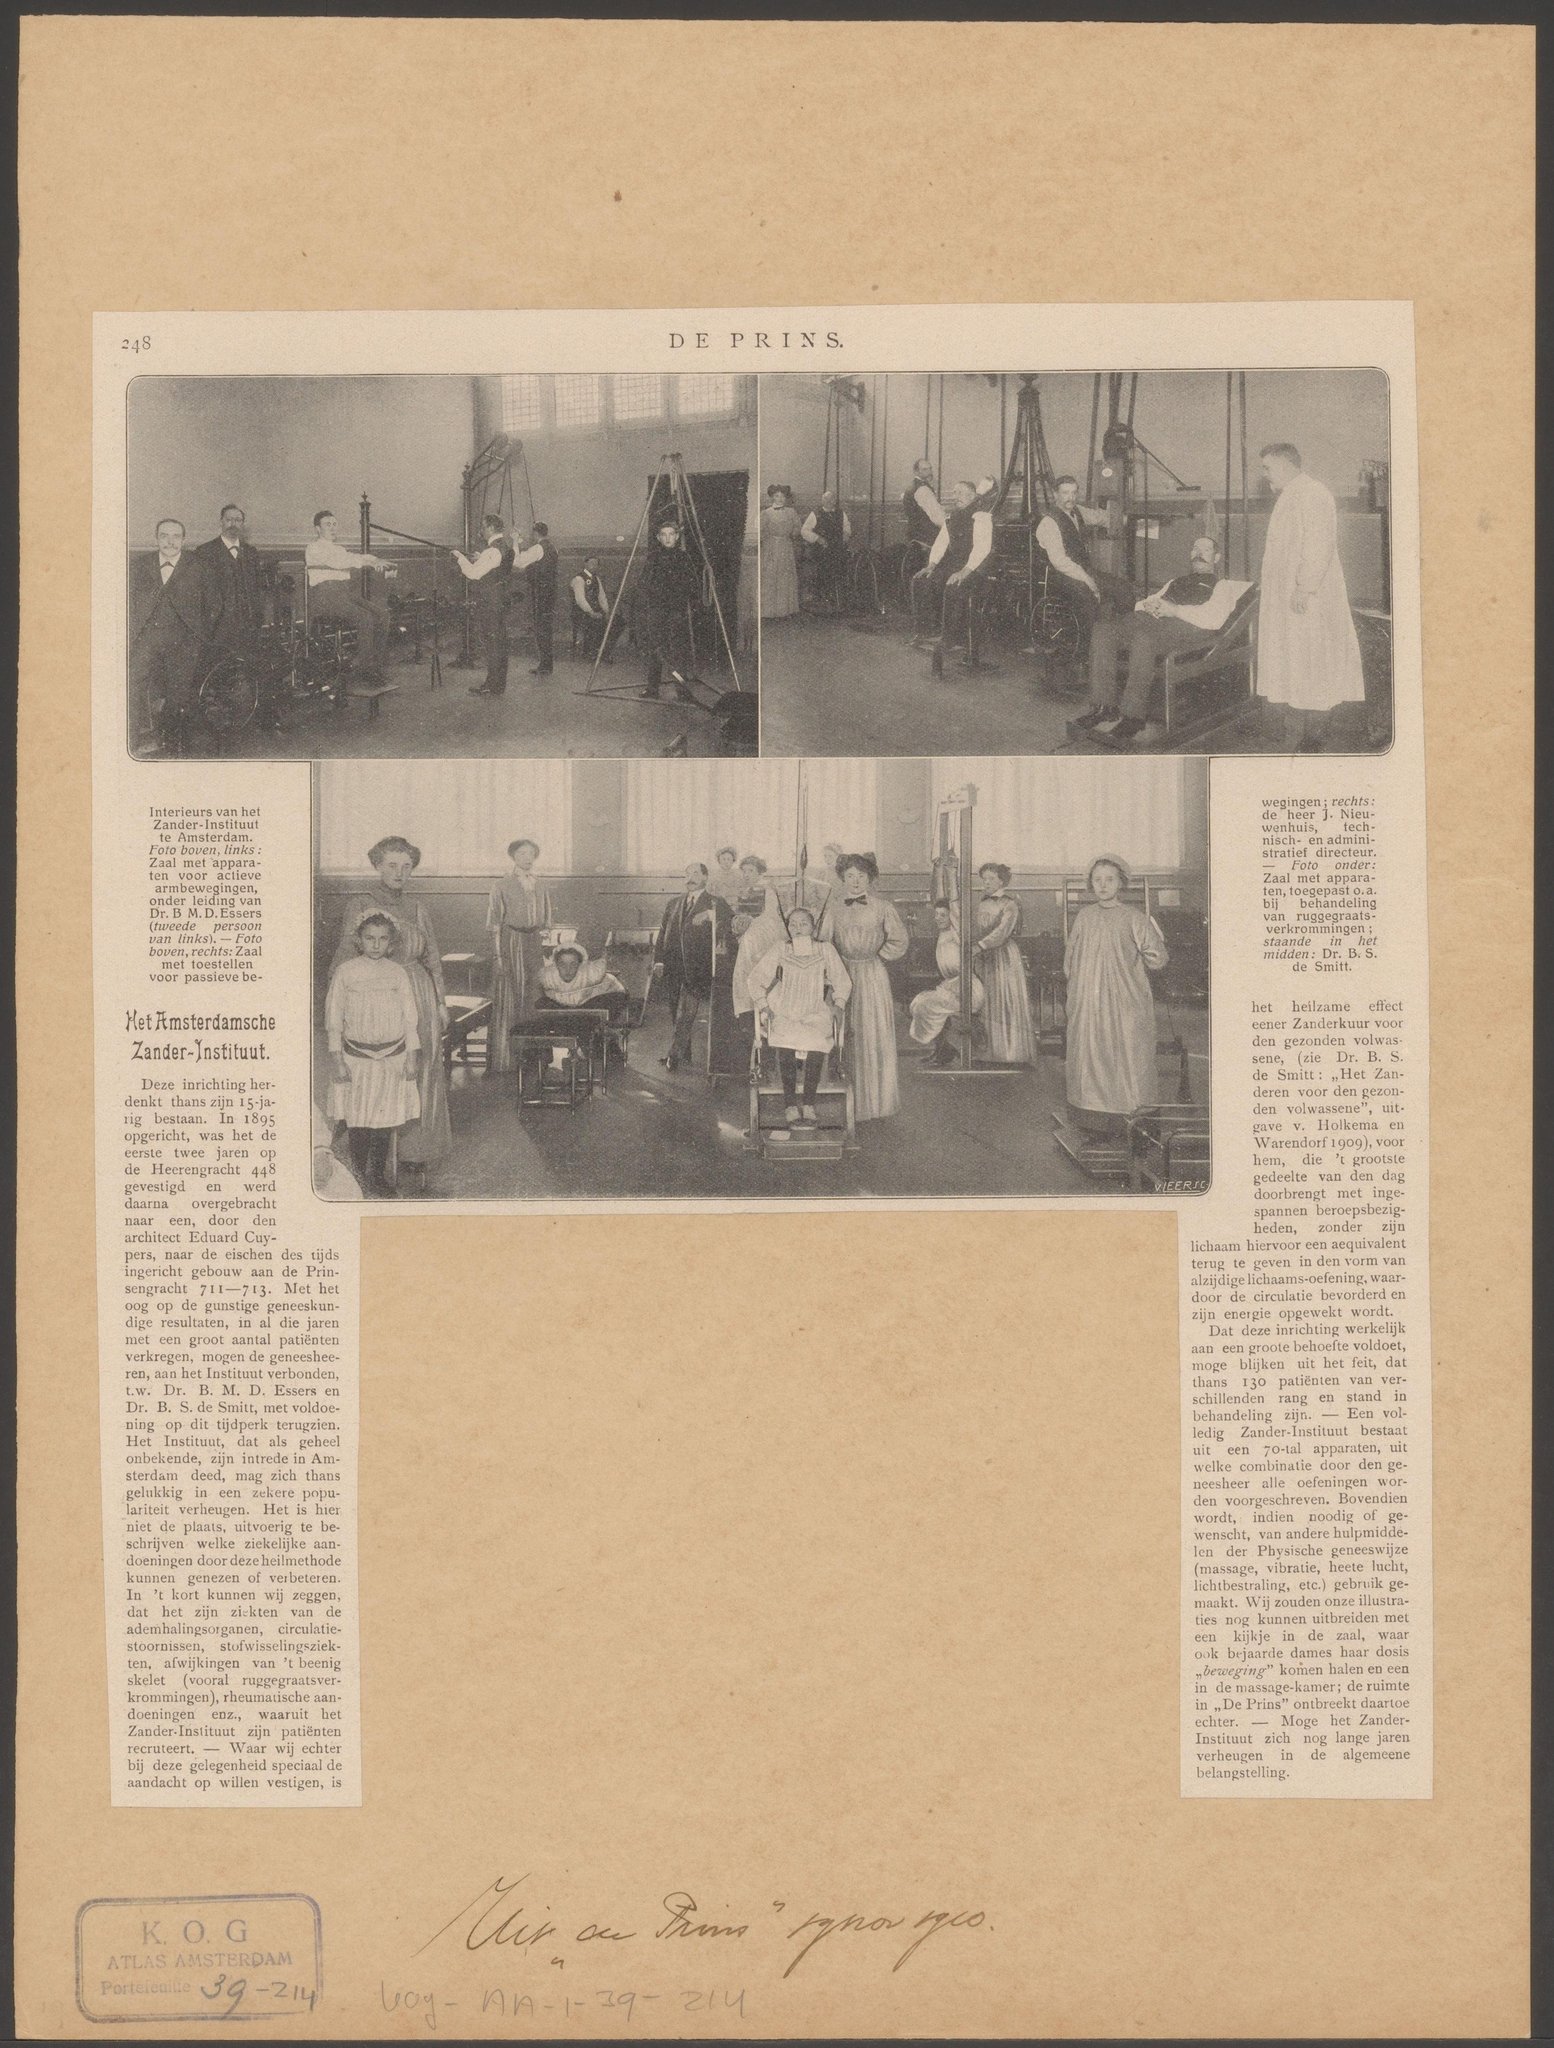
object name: photomechanical print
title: Het Amsterdamsche Zander-Instituut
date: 1910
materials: paper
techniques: letterpress printing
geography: amsterdam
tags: gymnastic exercises with apparatuses, patient, sick person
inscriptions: collector's mark: Lugt 1641b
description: Onderwerpsrubriek binnen de Atlas Amsterdam: Armwezen en liefdadige instellingen: V. Ziekenhuizen: Ver. voor Ziekenverpleging aan de Prinsengracht.